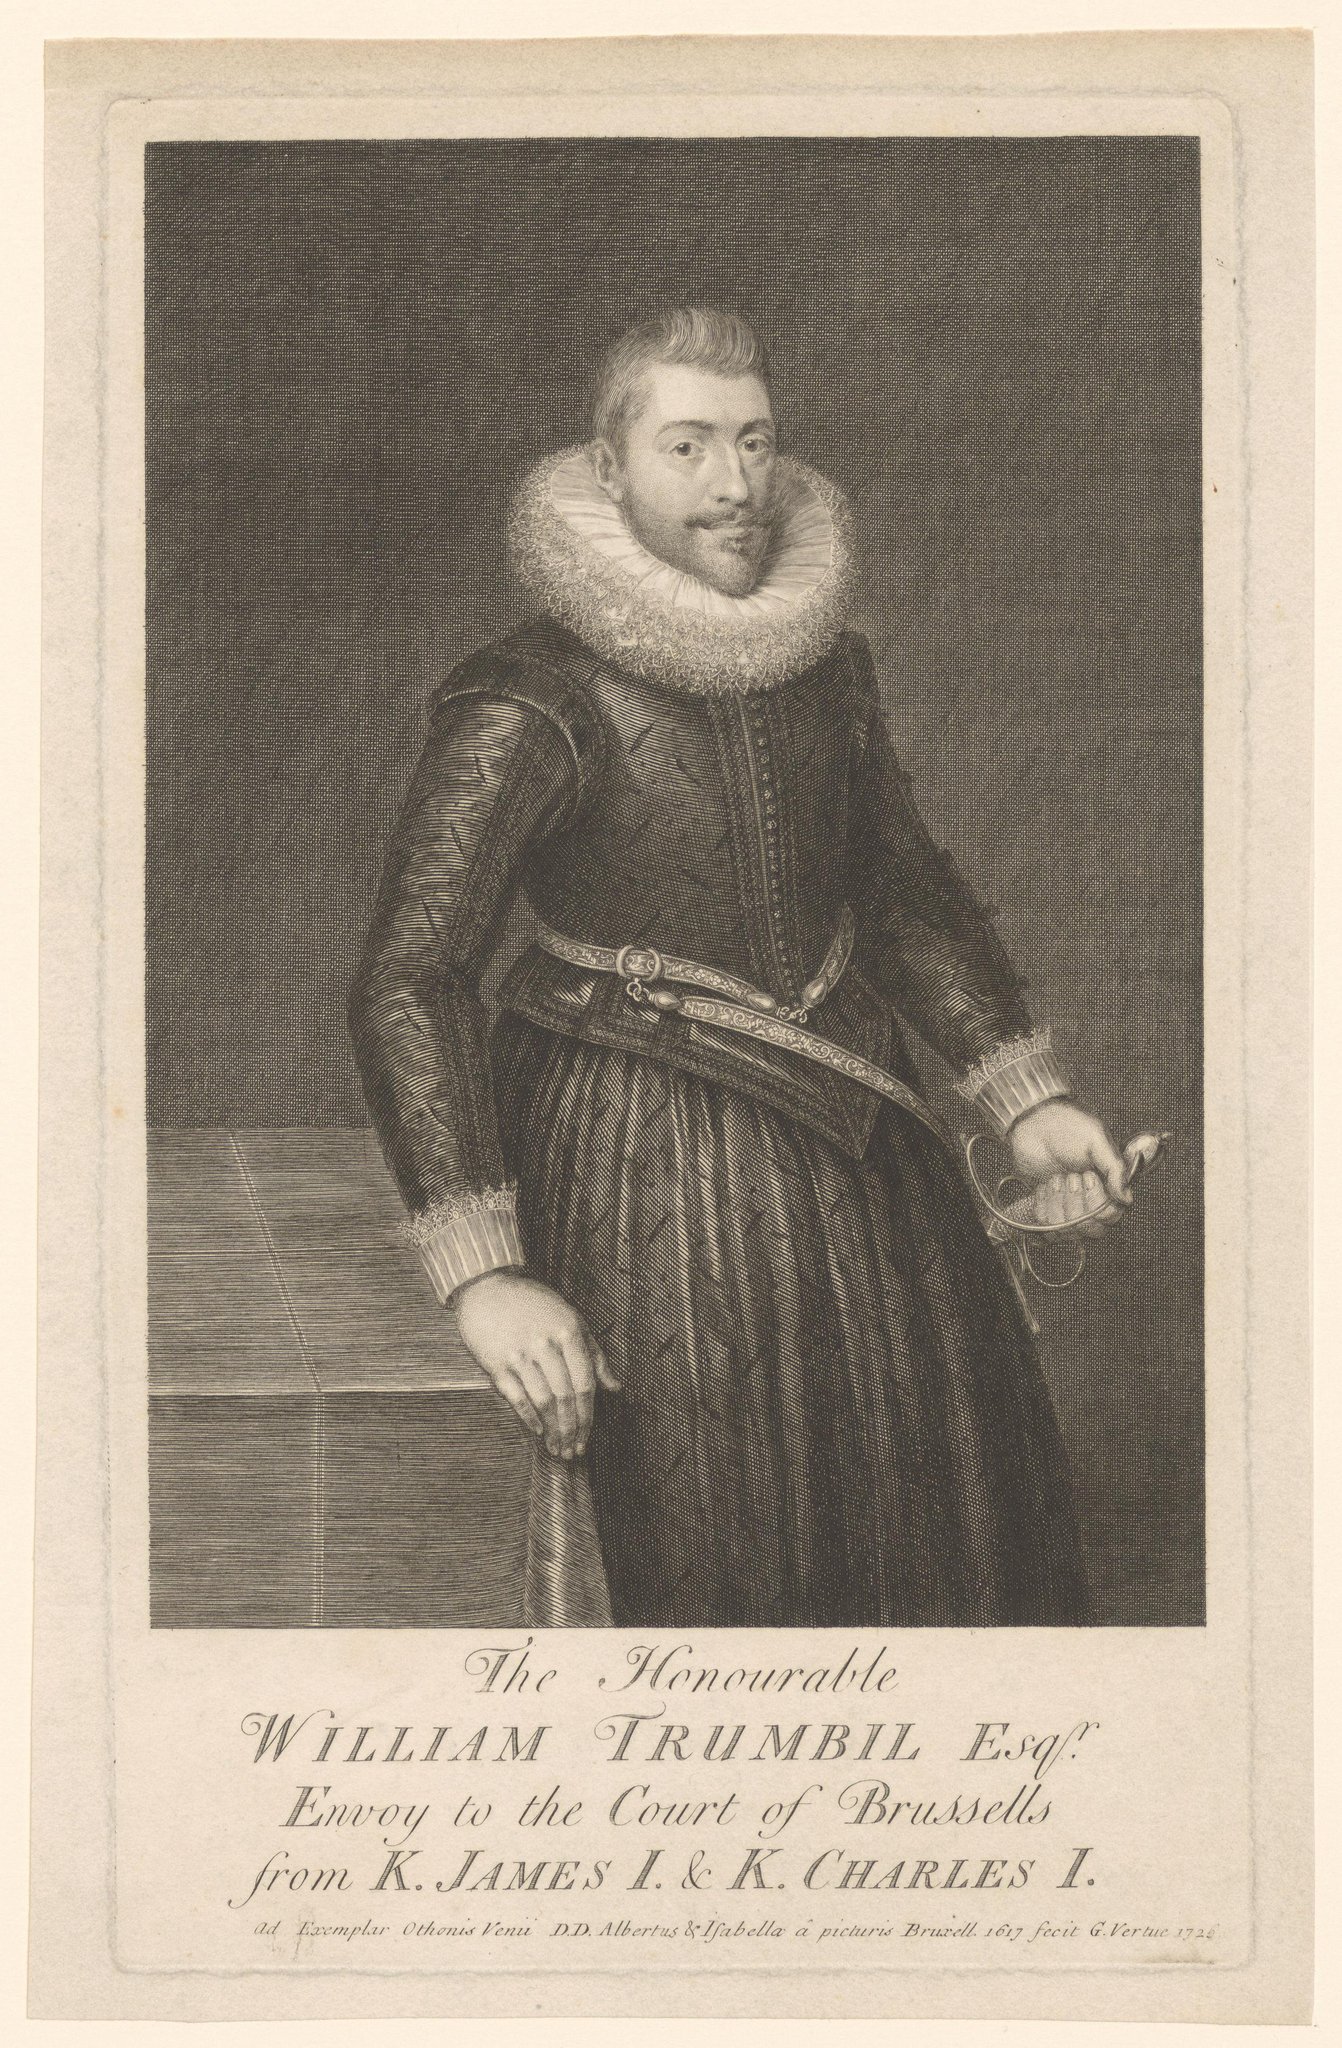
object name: print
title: Portret van William Trumbull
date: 1617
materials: paper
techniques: engraving, etching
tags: politician, historical persons, diplomacy, diplomat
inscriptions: collector's mark: Lugt 2228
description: Het schilderij waarnaar deze prent is gemaakt was oorspronkelijk opgedragen aan Isabella van Spanje en Albrecht van Oostenrijk in 1617.